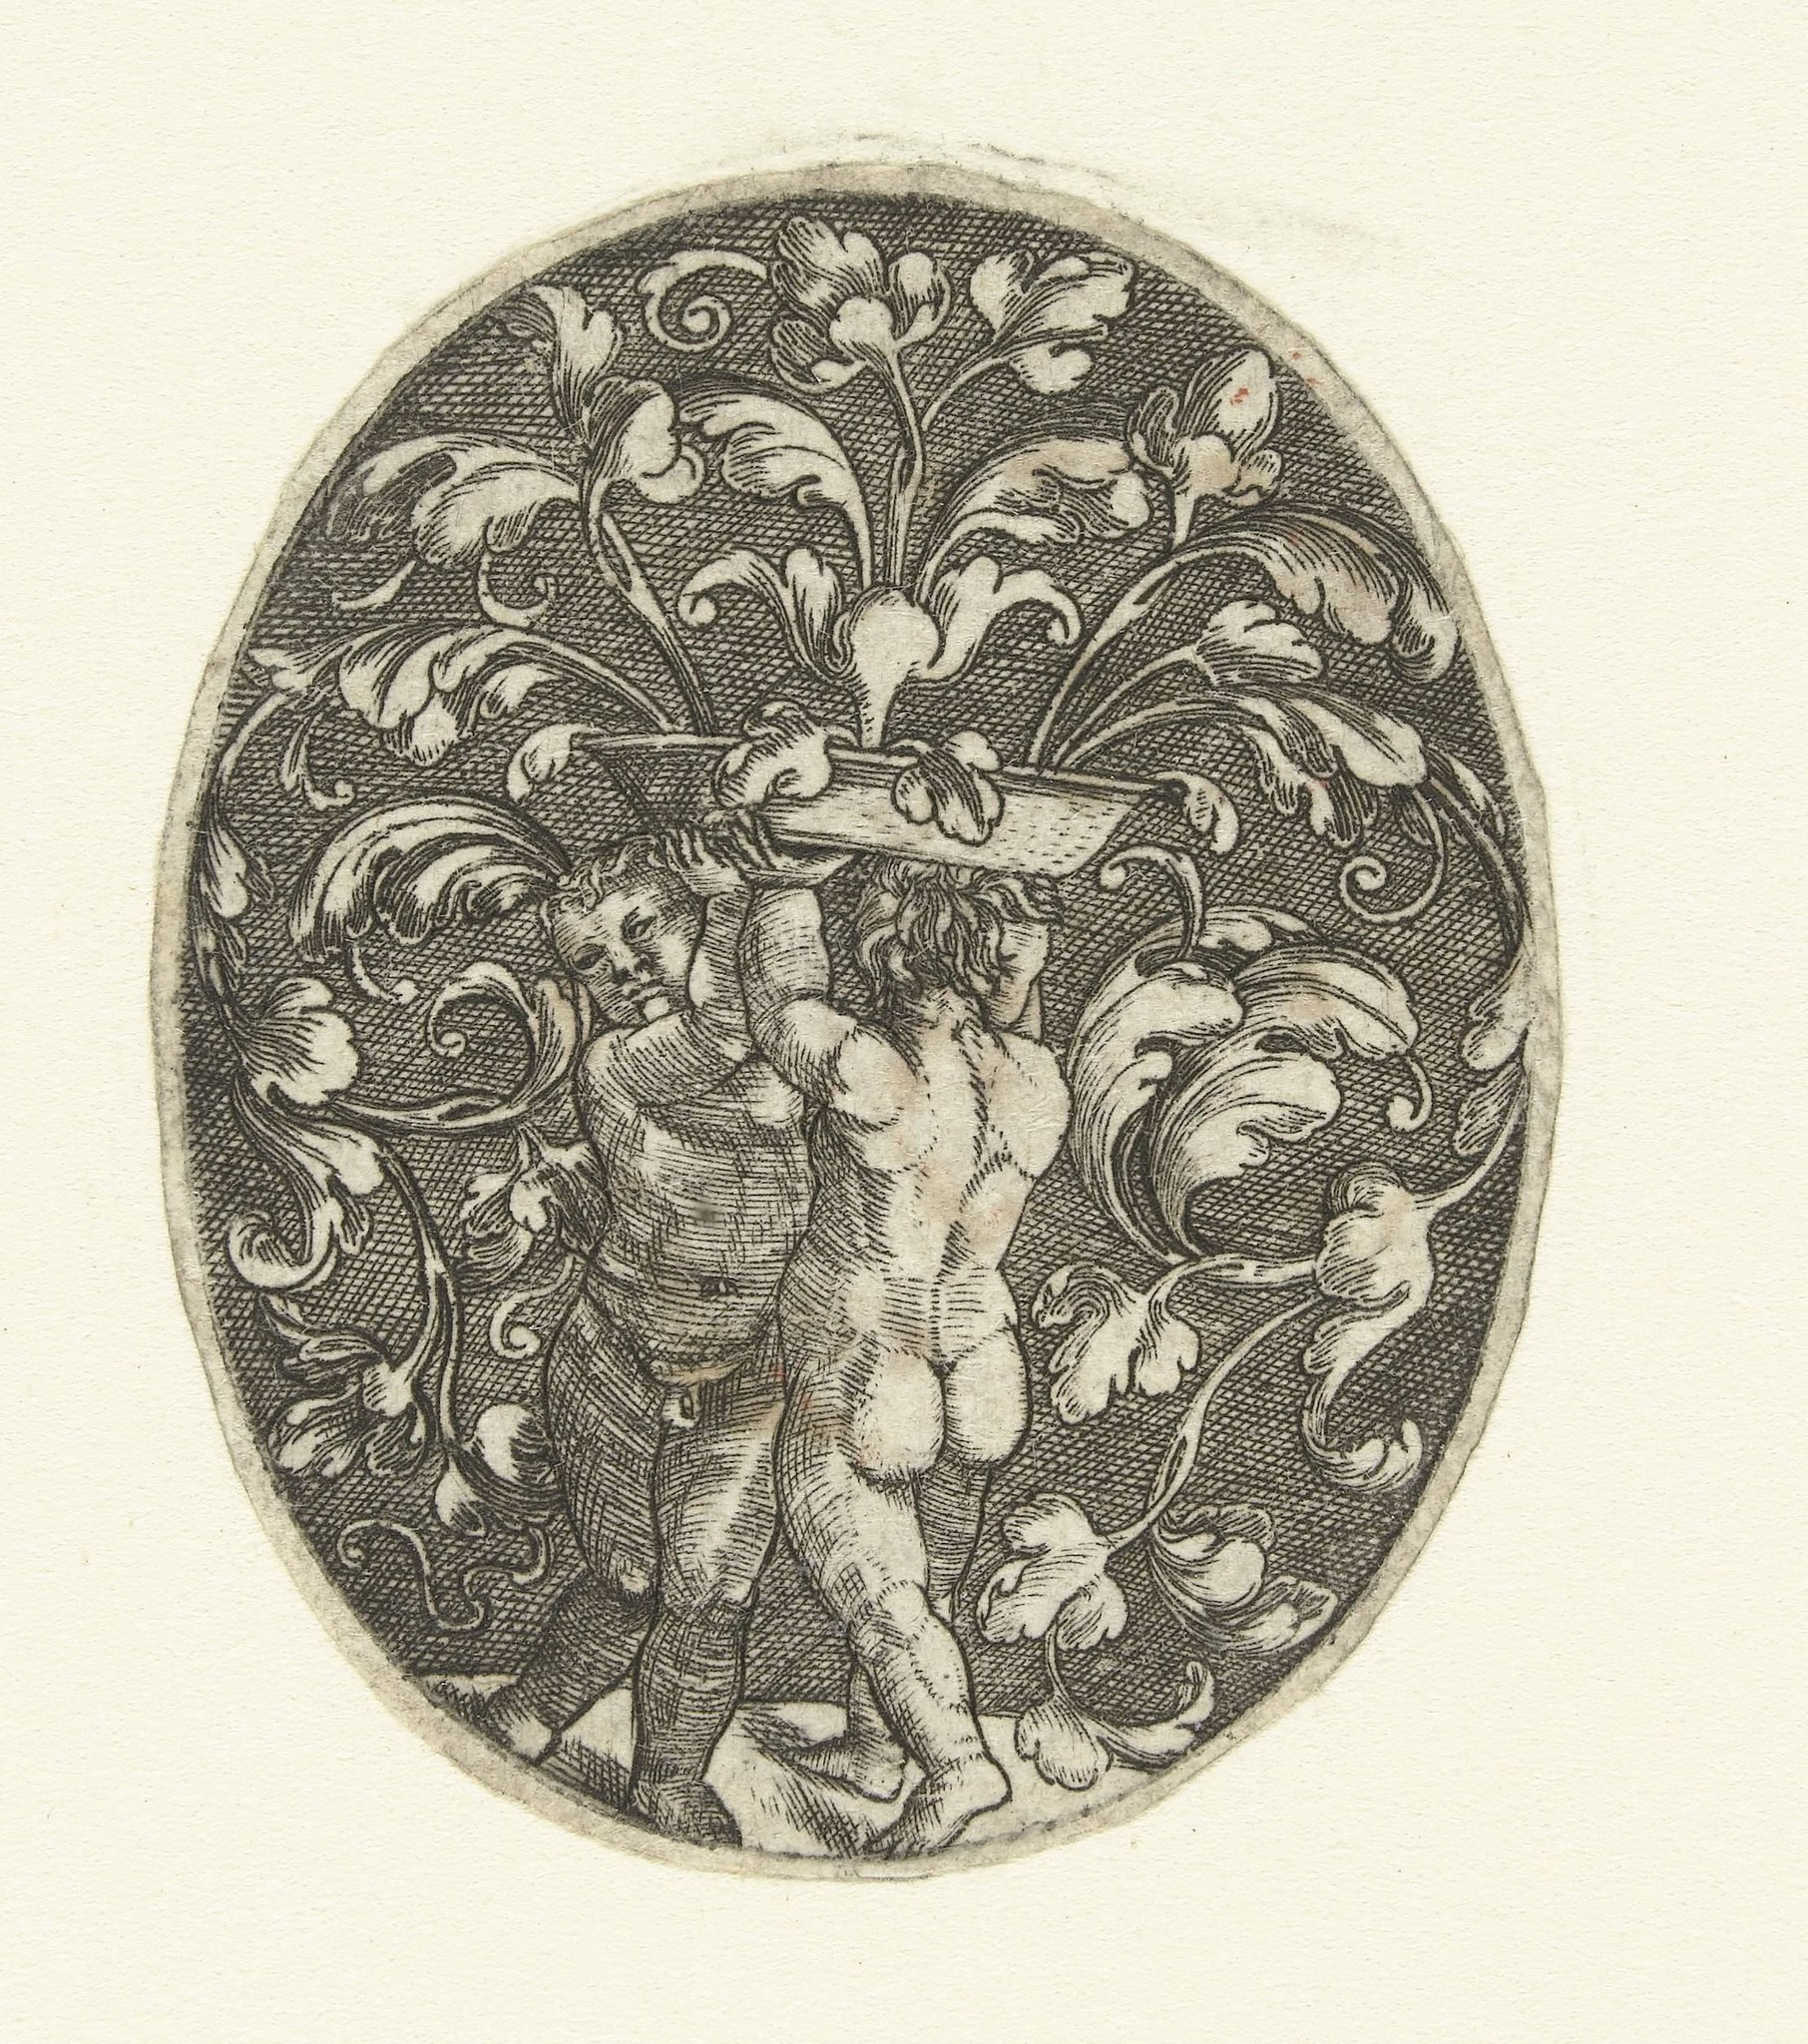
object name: print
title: Vlakdecoraties met bladranken en kinderen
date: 1500-1600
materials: paper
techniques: engraving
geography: germany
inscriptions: collector's mark: Lugt 240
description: Ovaal met twee kinderen die een schaal boven hun hoofden houden. Uit de schaal ontspruiten bladranken die het blad verder vullen. Gearceerde achtergrond. Eén van 4 bladen.